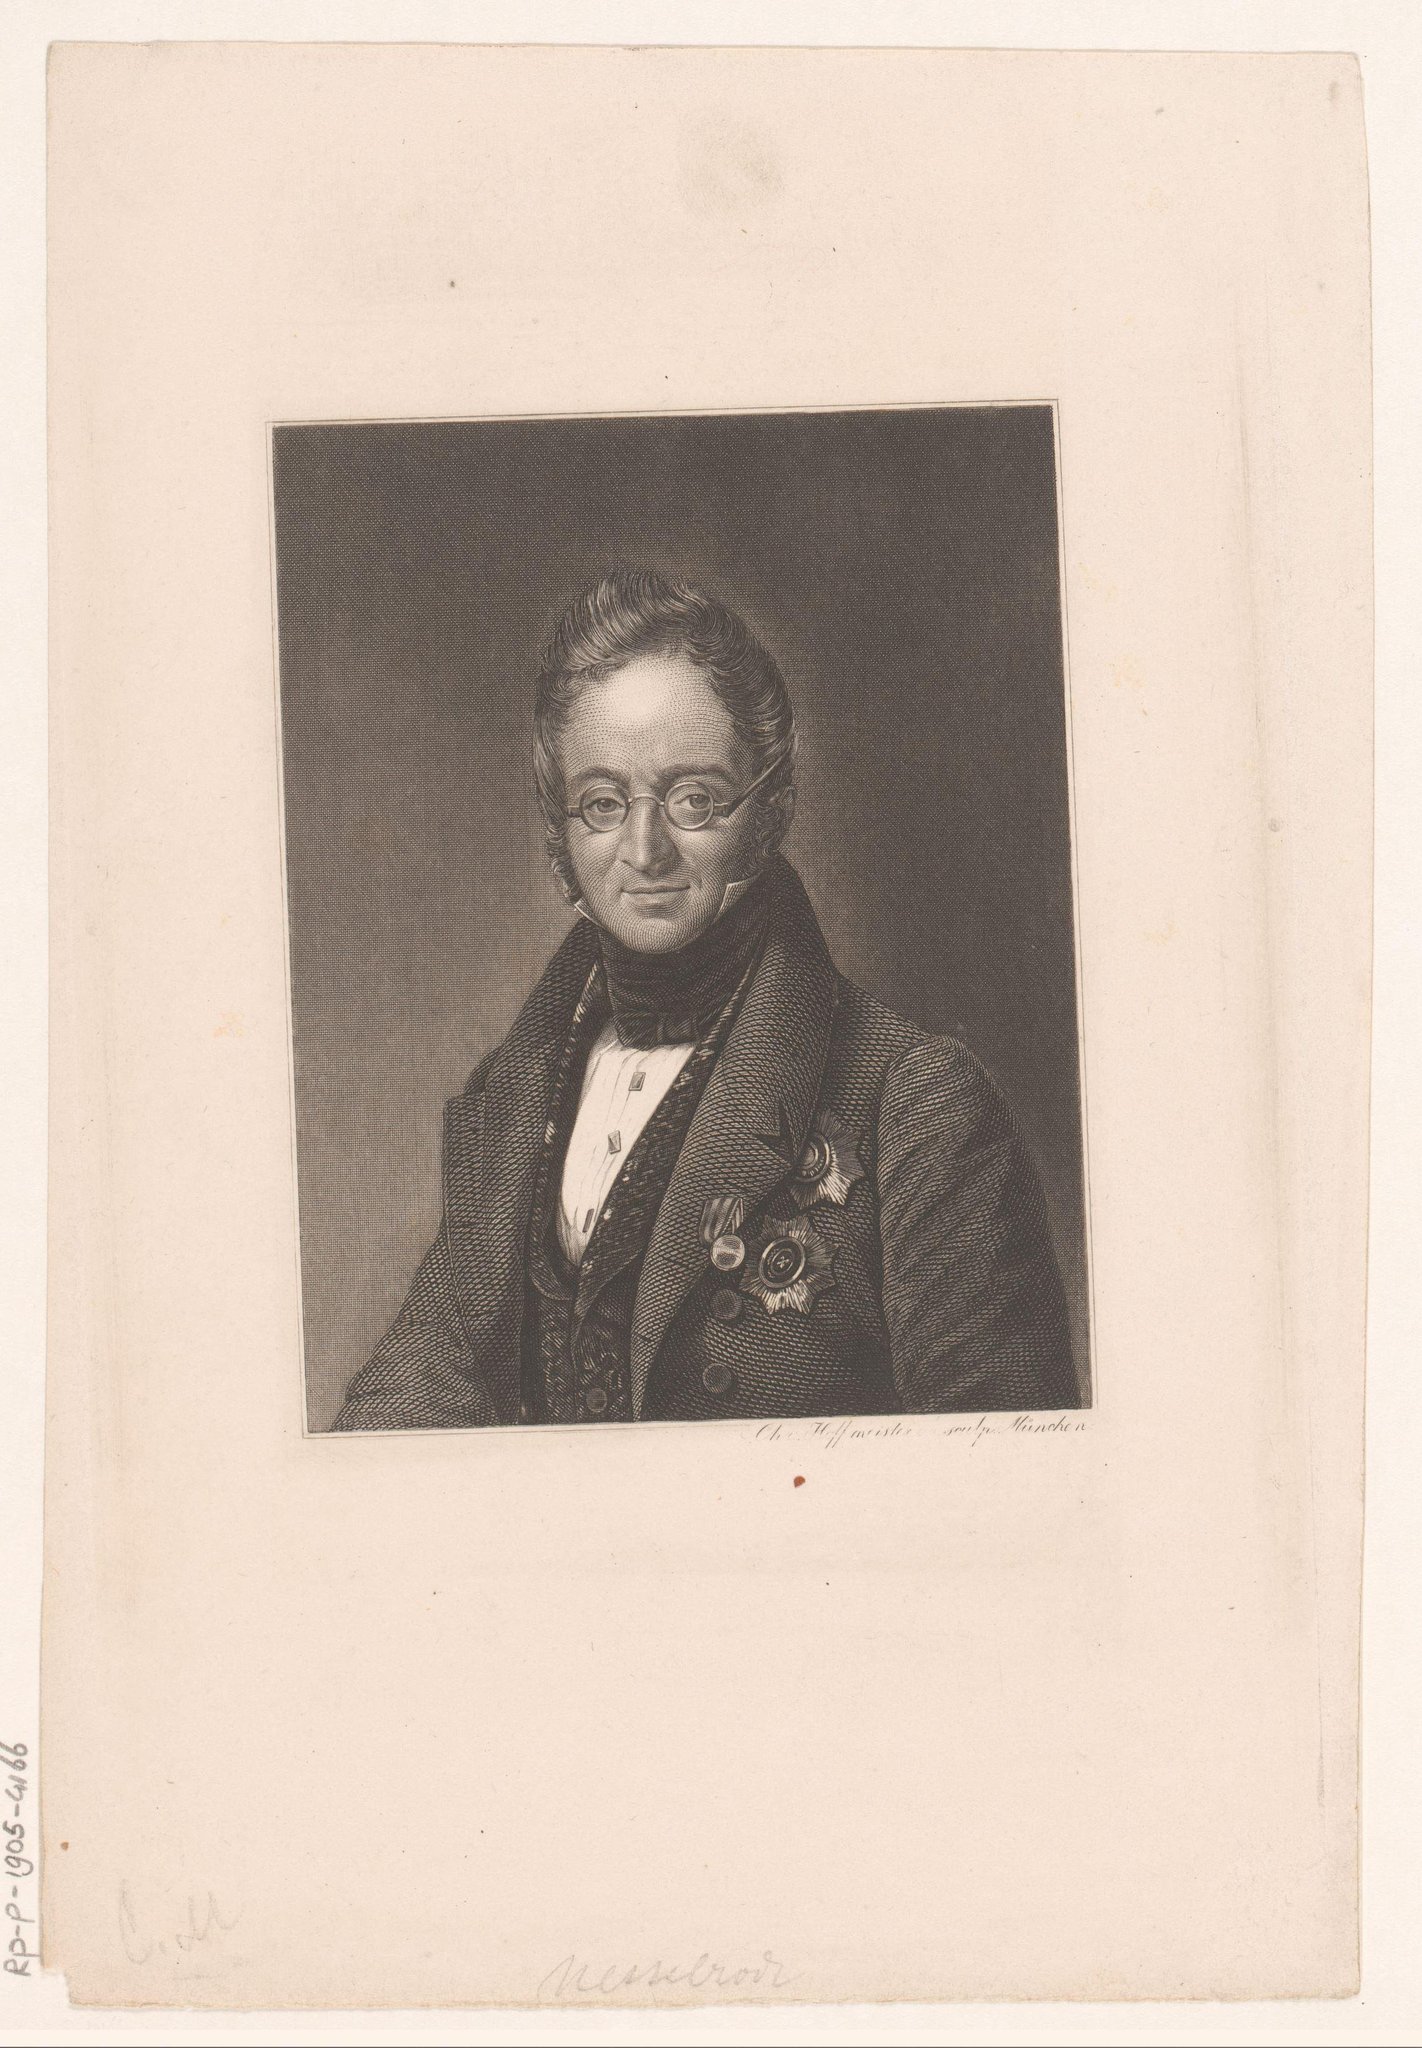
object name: print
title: Portret van een onbekende man, mogelijk de heer Nessebrode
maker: christian hoffmeister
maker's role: print maker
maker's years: 1818-1871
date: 1828-1871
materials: paper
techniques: engraving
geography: munich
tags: eyeglasses, spectacles, knighthood order, historical persons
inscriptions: collector's mark: Lugt 2228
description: Geïnventariseerd als het portret van de heer Nessebrode.